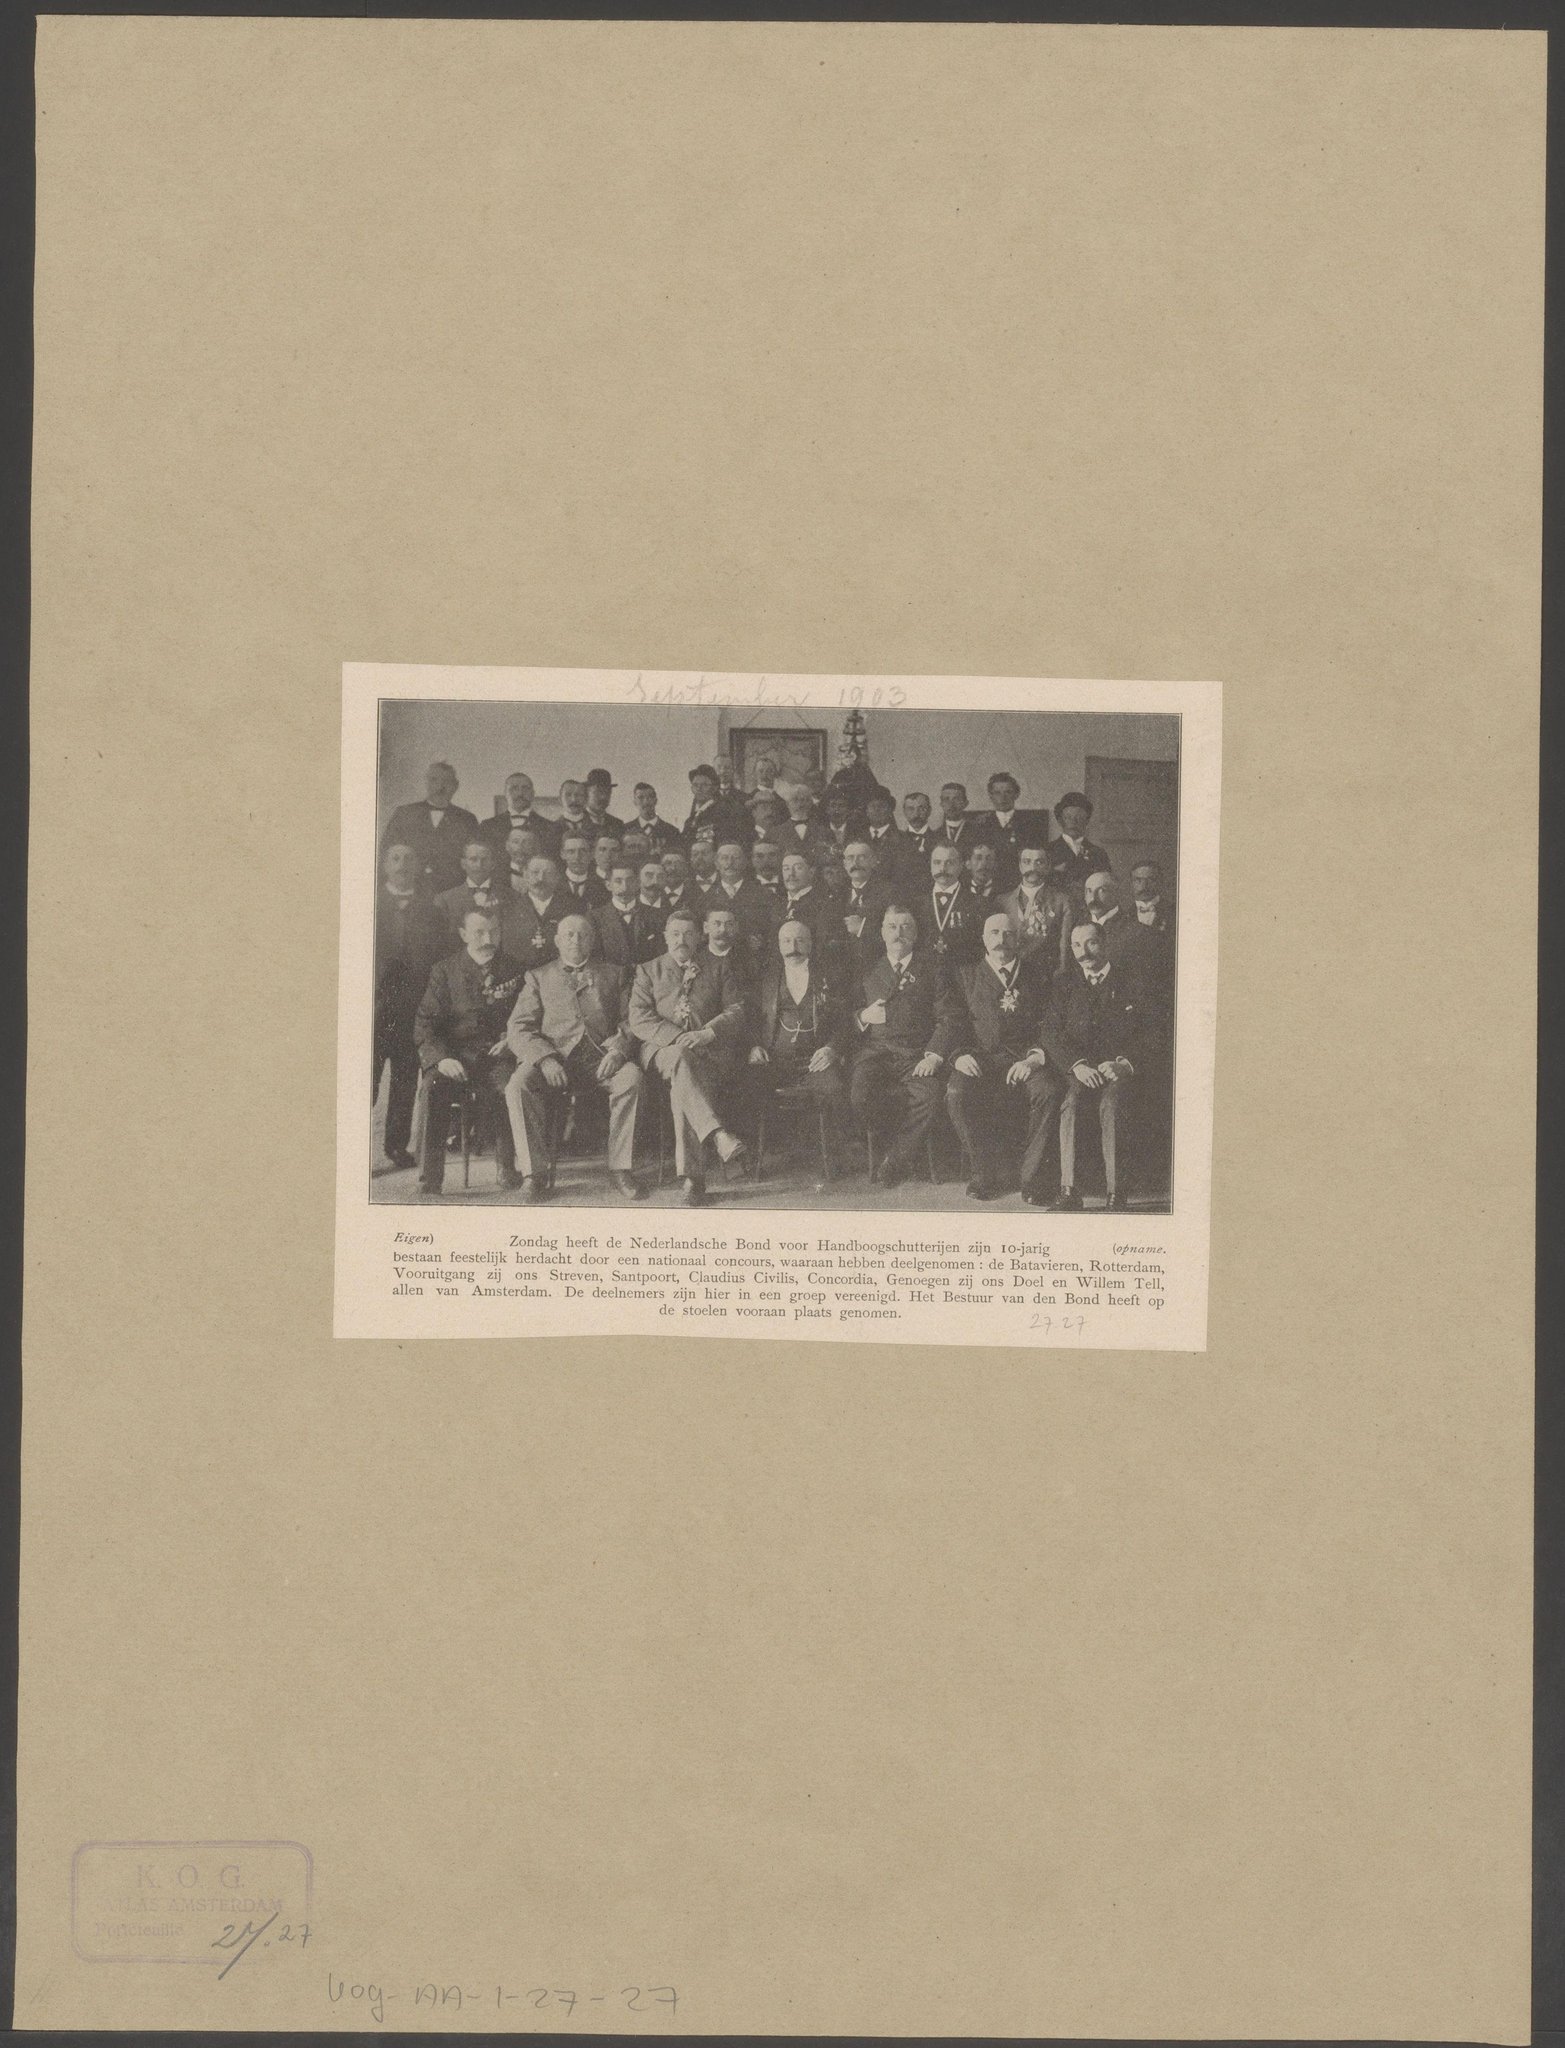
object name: photomechanical print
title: Leden van de Nederlandsche Bond voor Handboogschutterijen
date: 1903-1909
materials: paper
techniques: letterpress printing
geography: amsterdam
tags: corporative organization, guild, historical persons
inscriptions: collector's mark: Lugt 1641b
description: Onderwerpsrubriek binnen de Atlas Amsterdam: Landmacht: Gebouwen / Herinneringen aan officieren, stadssoldaten / Nationale militie / (diverse korpsen) / Padvinders / Parade.